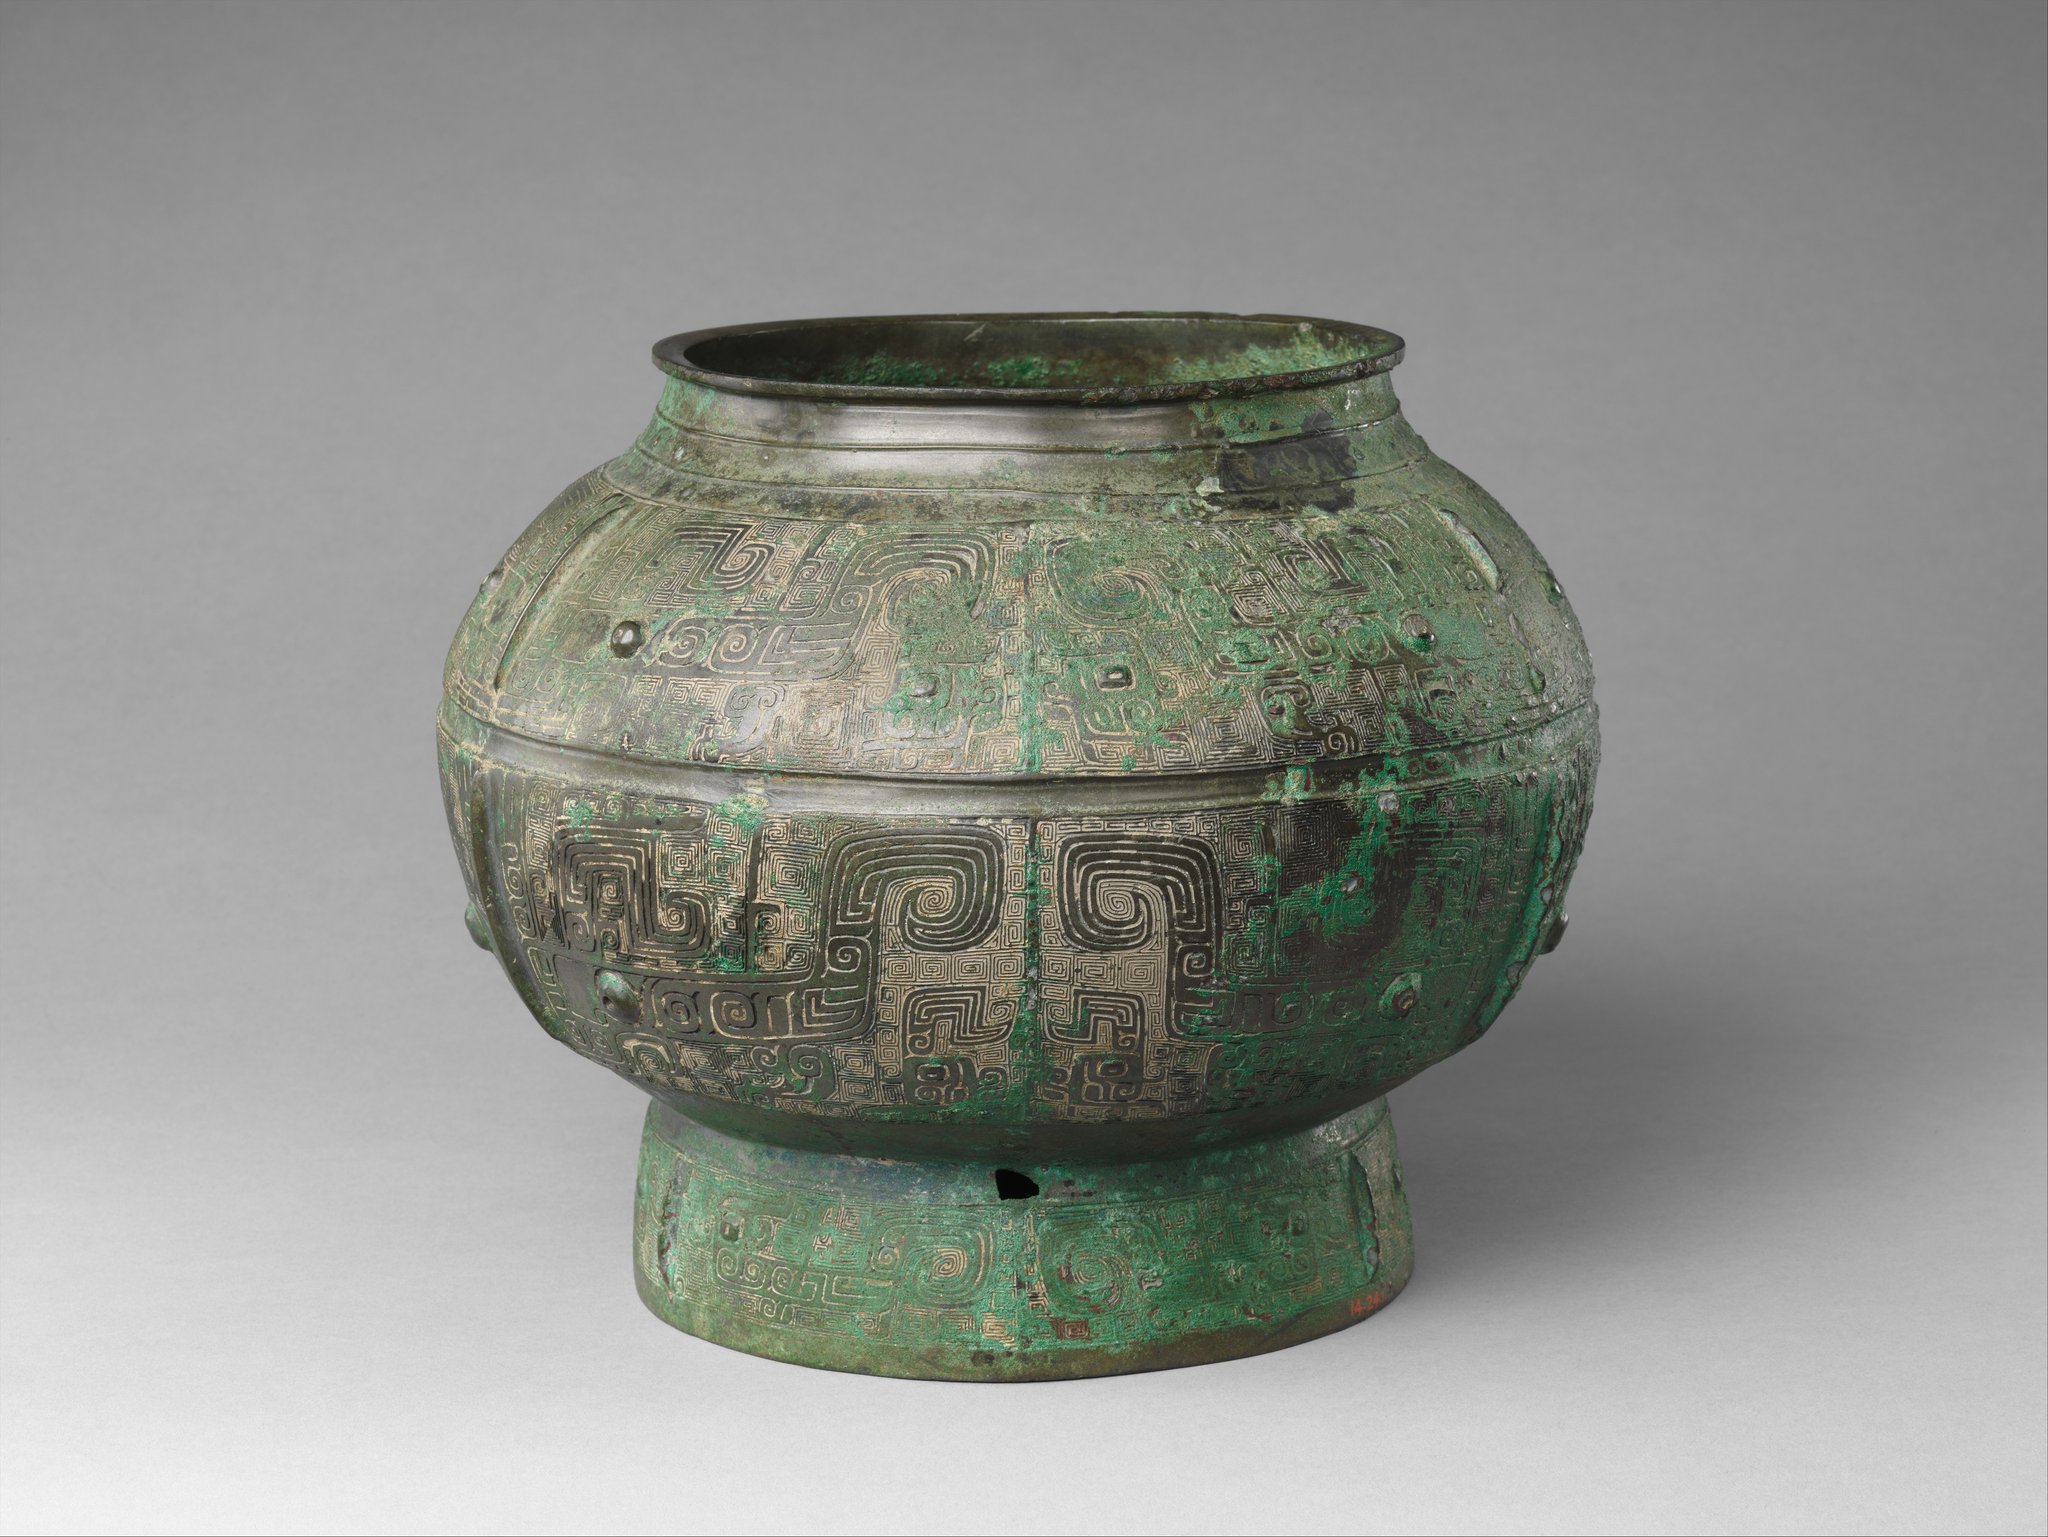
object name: wine container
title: Wine Container (Pou)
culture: chinese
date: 1400-1201 BCE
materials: bronze